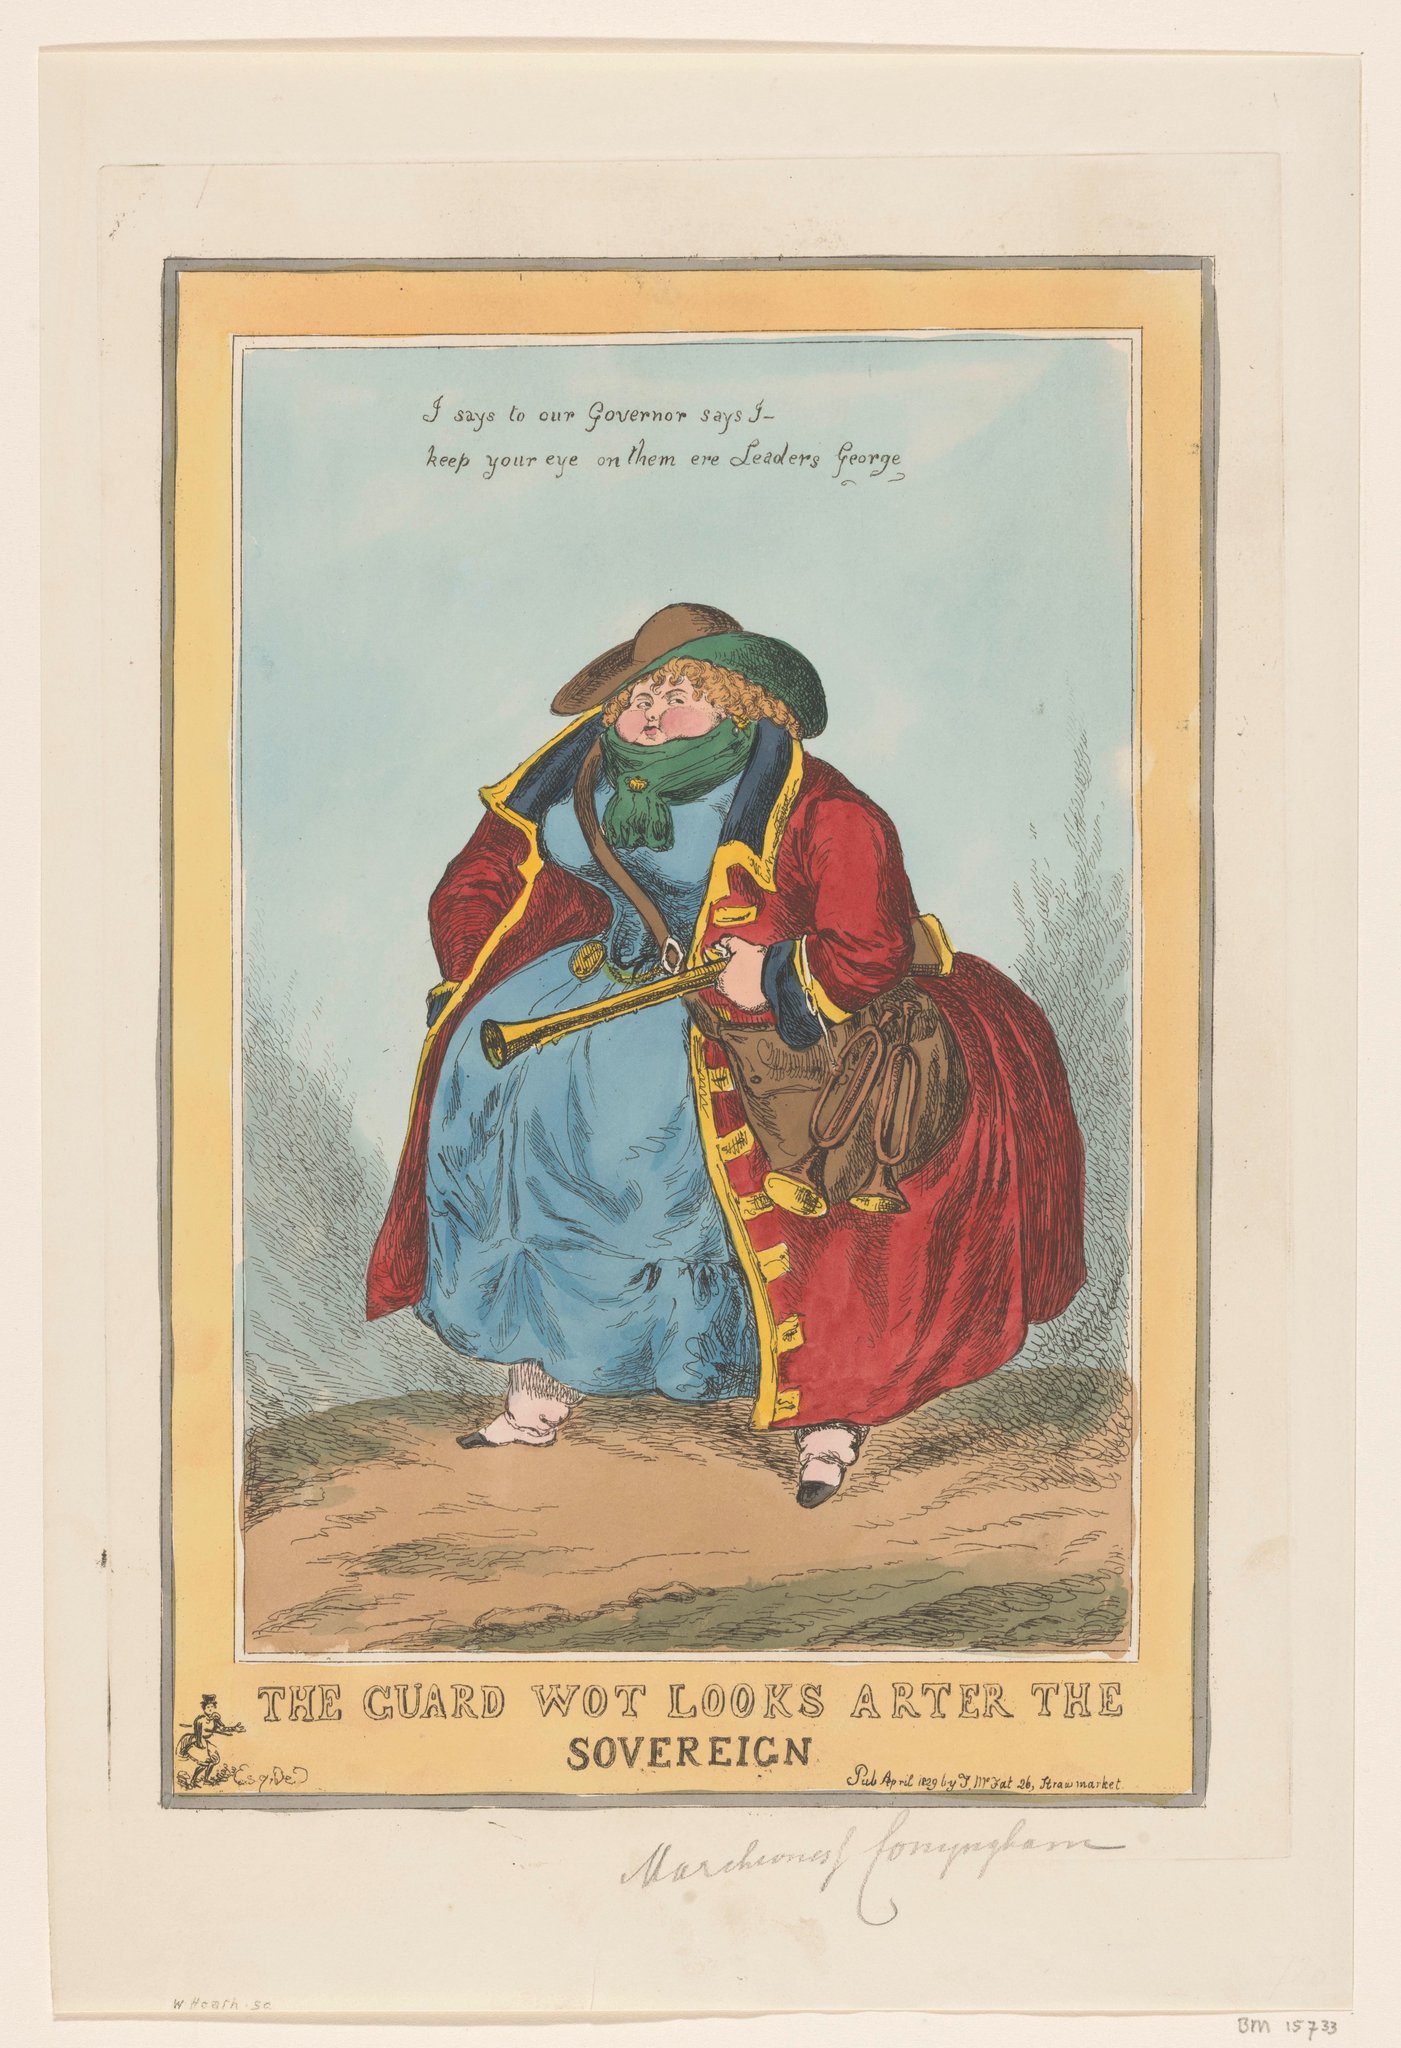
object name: print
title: The guard wot looks arter the sovereign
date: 1804-1829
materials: paper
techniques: etching, hand coloring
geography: london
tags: horn, trumpet, cornet, trombone, tuba, firearms: rifle, fashionable woman, 'belle'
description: Spotprent met een voorstelling van een zeer gezette Lady Conyngham, de maîtresse van koning George IV, als een stoere modieuze figuur, staande met de benen uit elkaar, in een lange rode jas en een hoed met brede rand. In de hand een geweer, om de schouders een tas en twee trompetten. Zie ook de pendant.